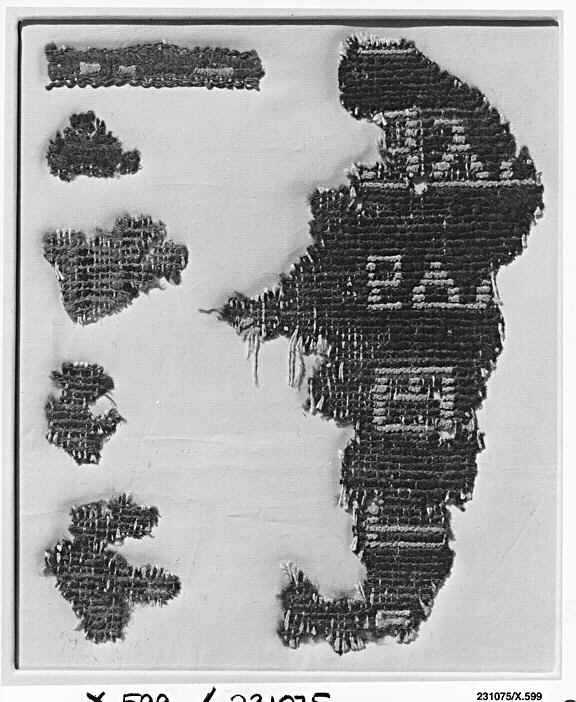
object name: textile fragment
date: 801-1000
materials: wool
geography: egypt